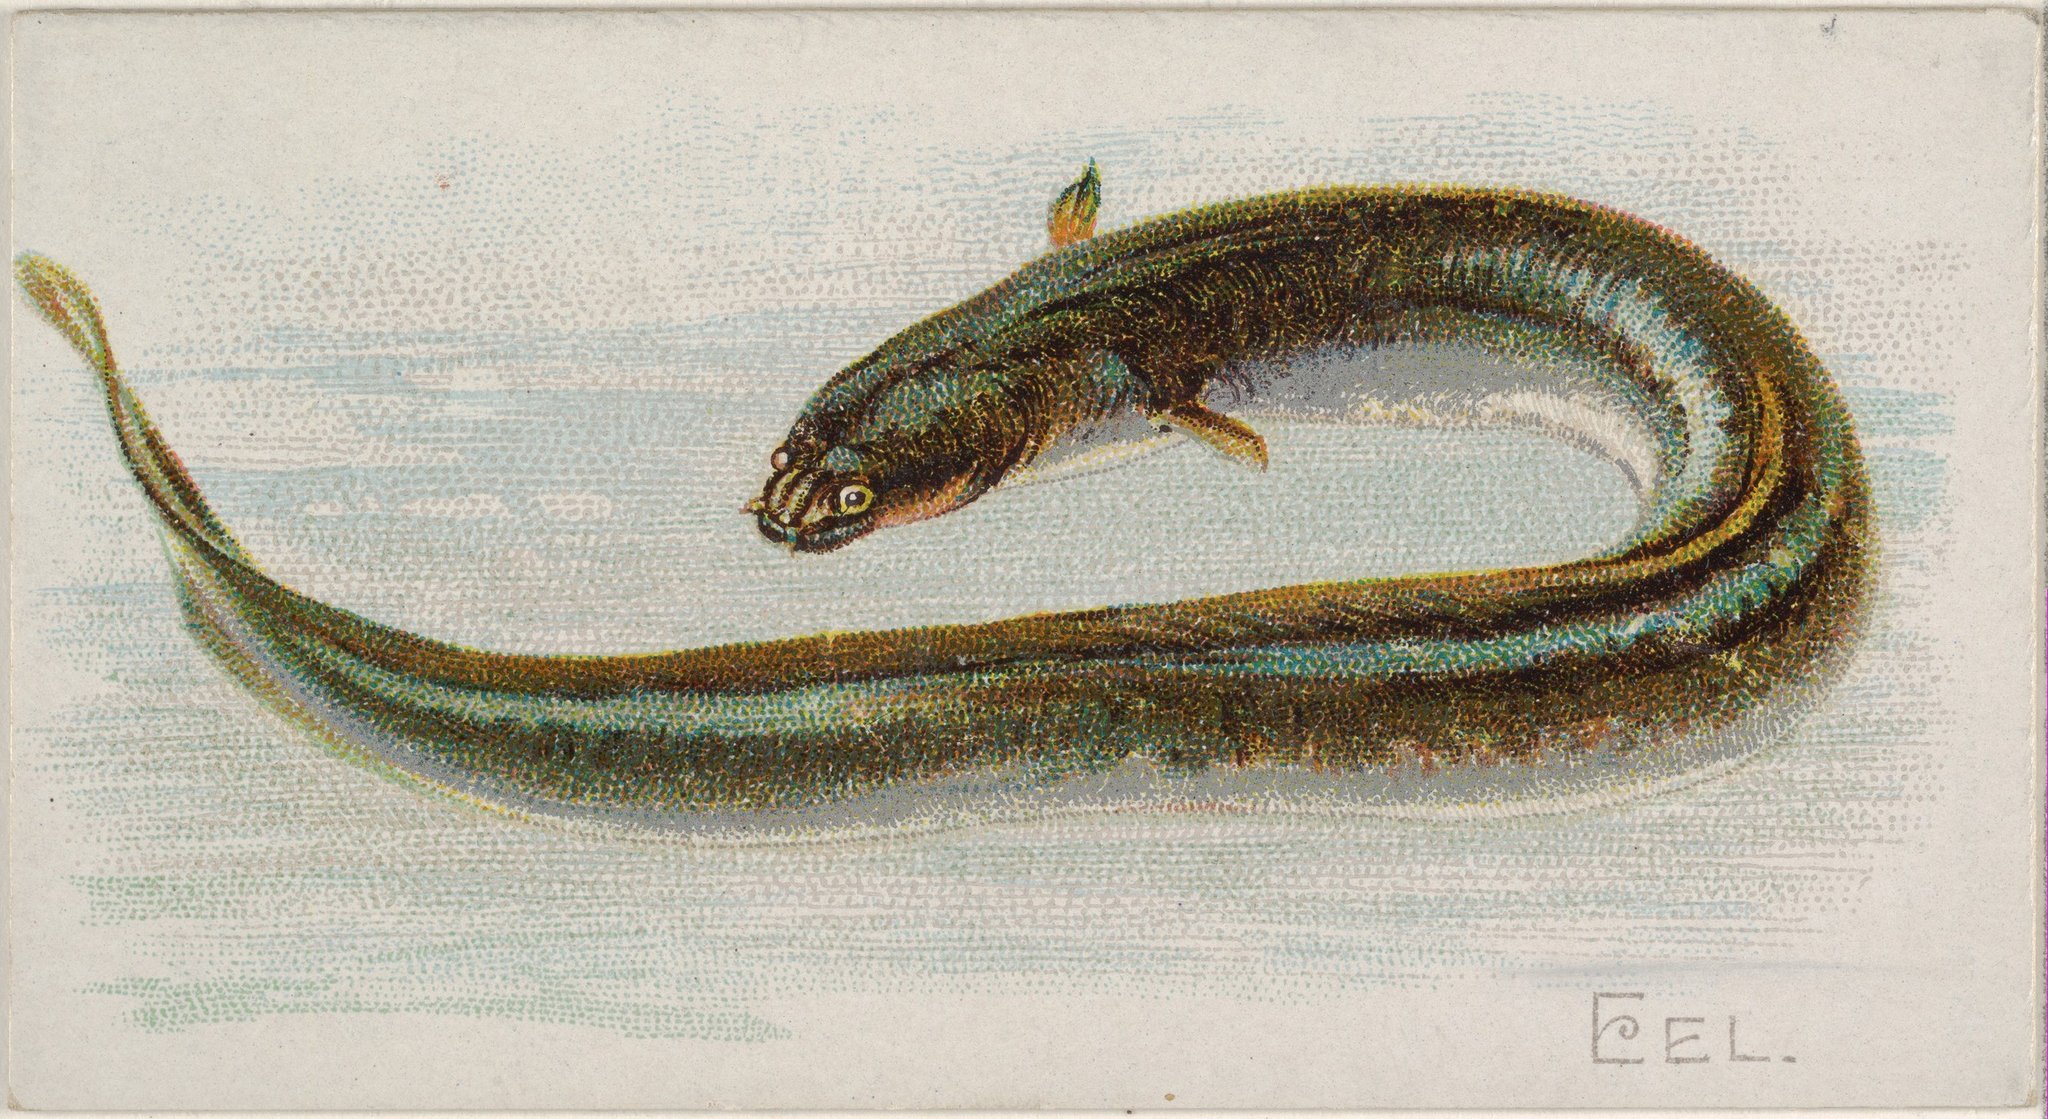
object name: print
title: Eel, from the Fish from American Waters series (N8) for Allen & Ginter Cigarettes Brands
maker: allen & ginter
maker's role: publisher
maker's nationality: american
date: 1889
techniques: color lithograph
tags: fish